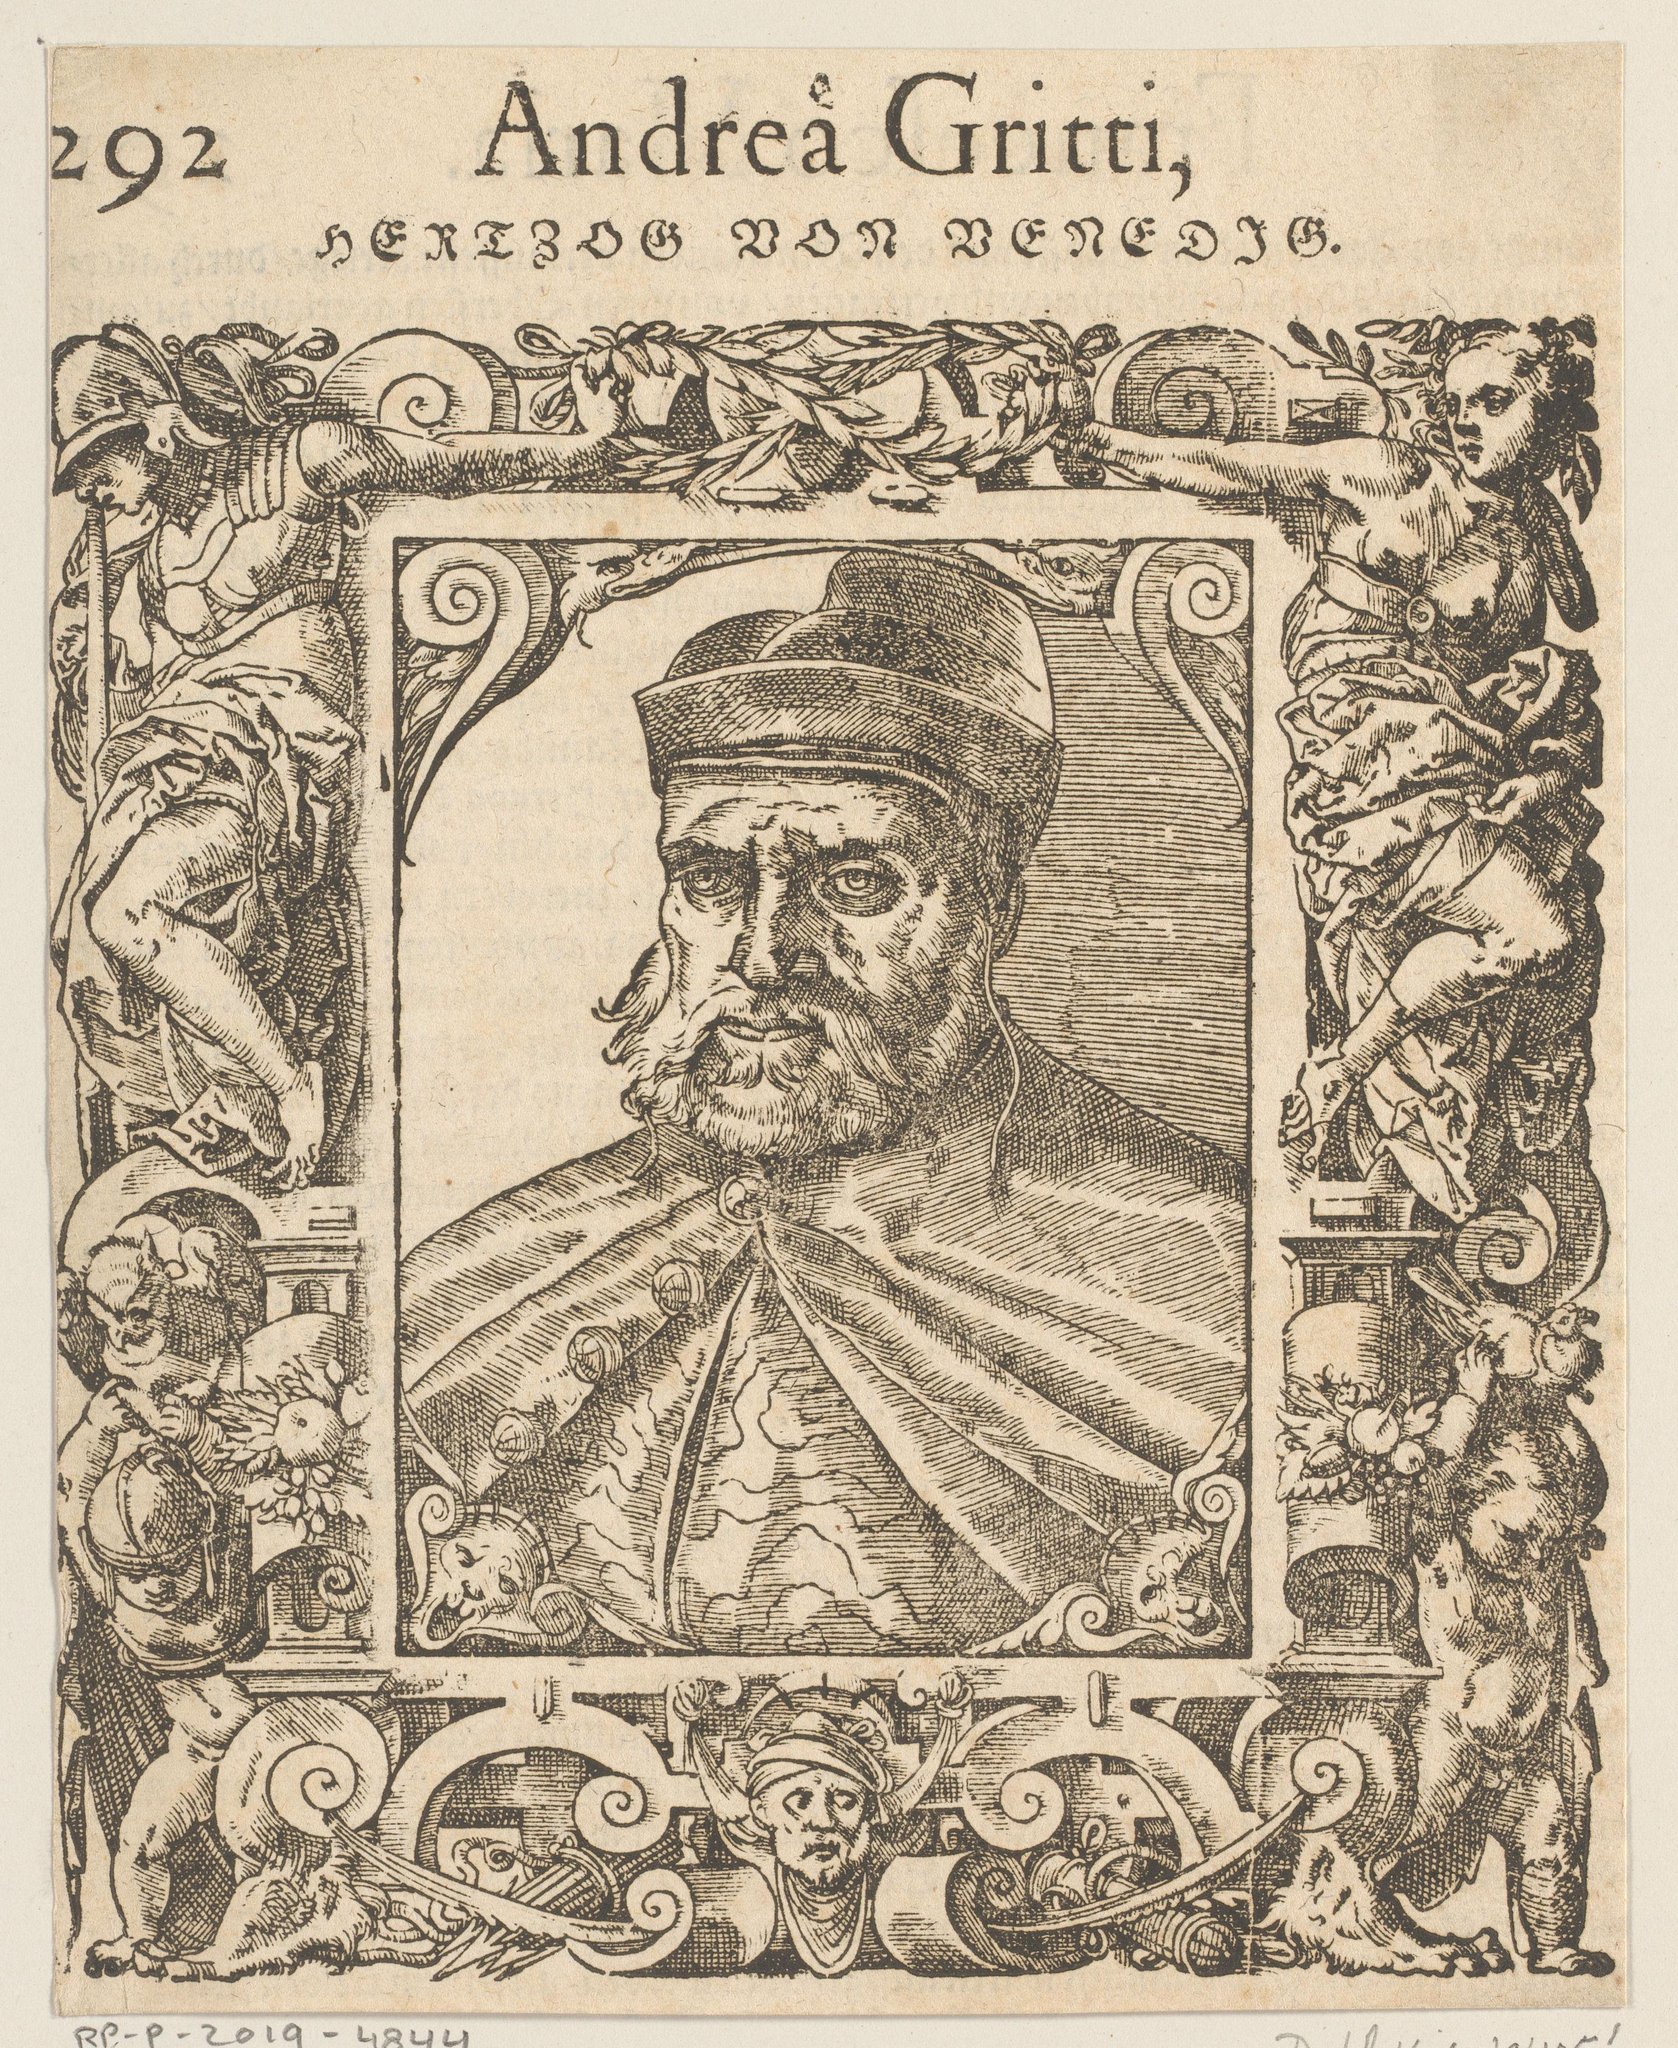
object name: book illustration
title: Portret van Andrea Gritti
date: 1587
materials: paper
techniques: letterpress printing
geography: basel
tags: venice, politician, historical persons, other sovereign: doge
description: Prent uit: Warhafftiger kurtzer Bericht von mannigerley Kriegs und anderen fürnemen (...). Bazel: Konrad Waldkirch, 1587, p. 292. Prent eerder verschenen in: Giovio, Paolo. Elogia virorum bellica virtute illustrium (...). Bazel: Peter Perna, 1575. Prent mogelijk ook gebruikt in latere publicaties.